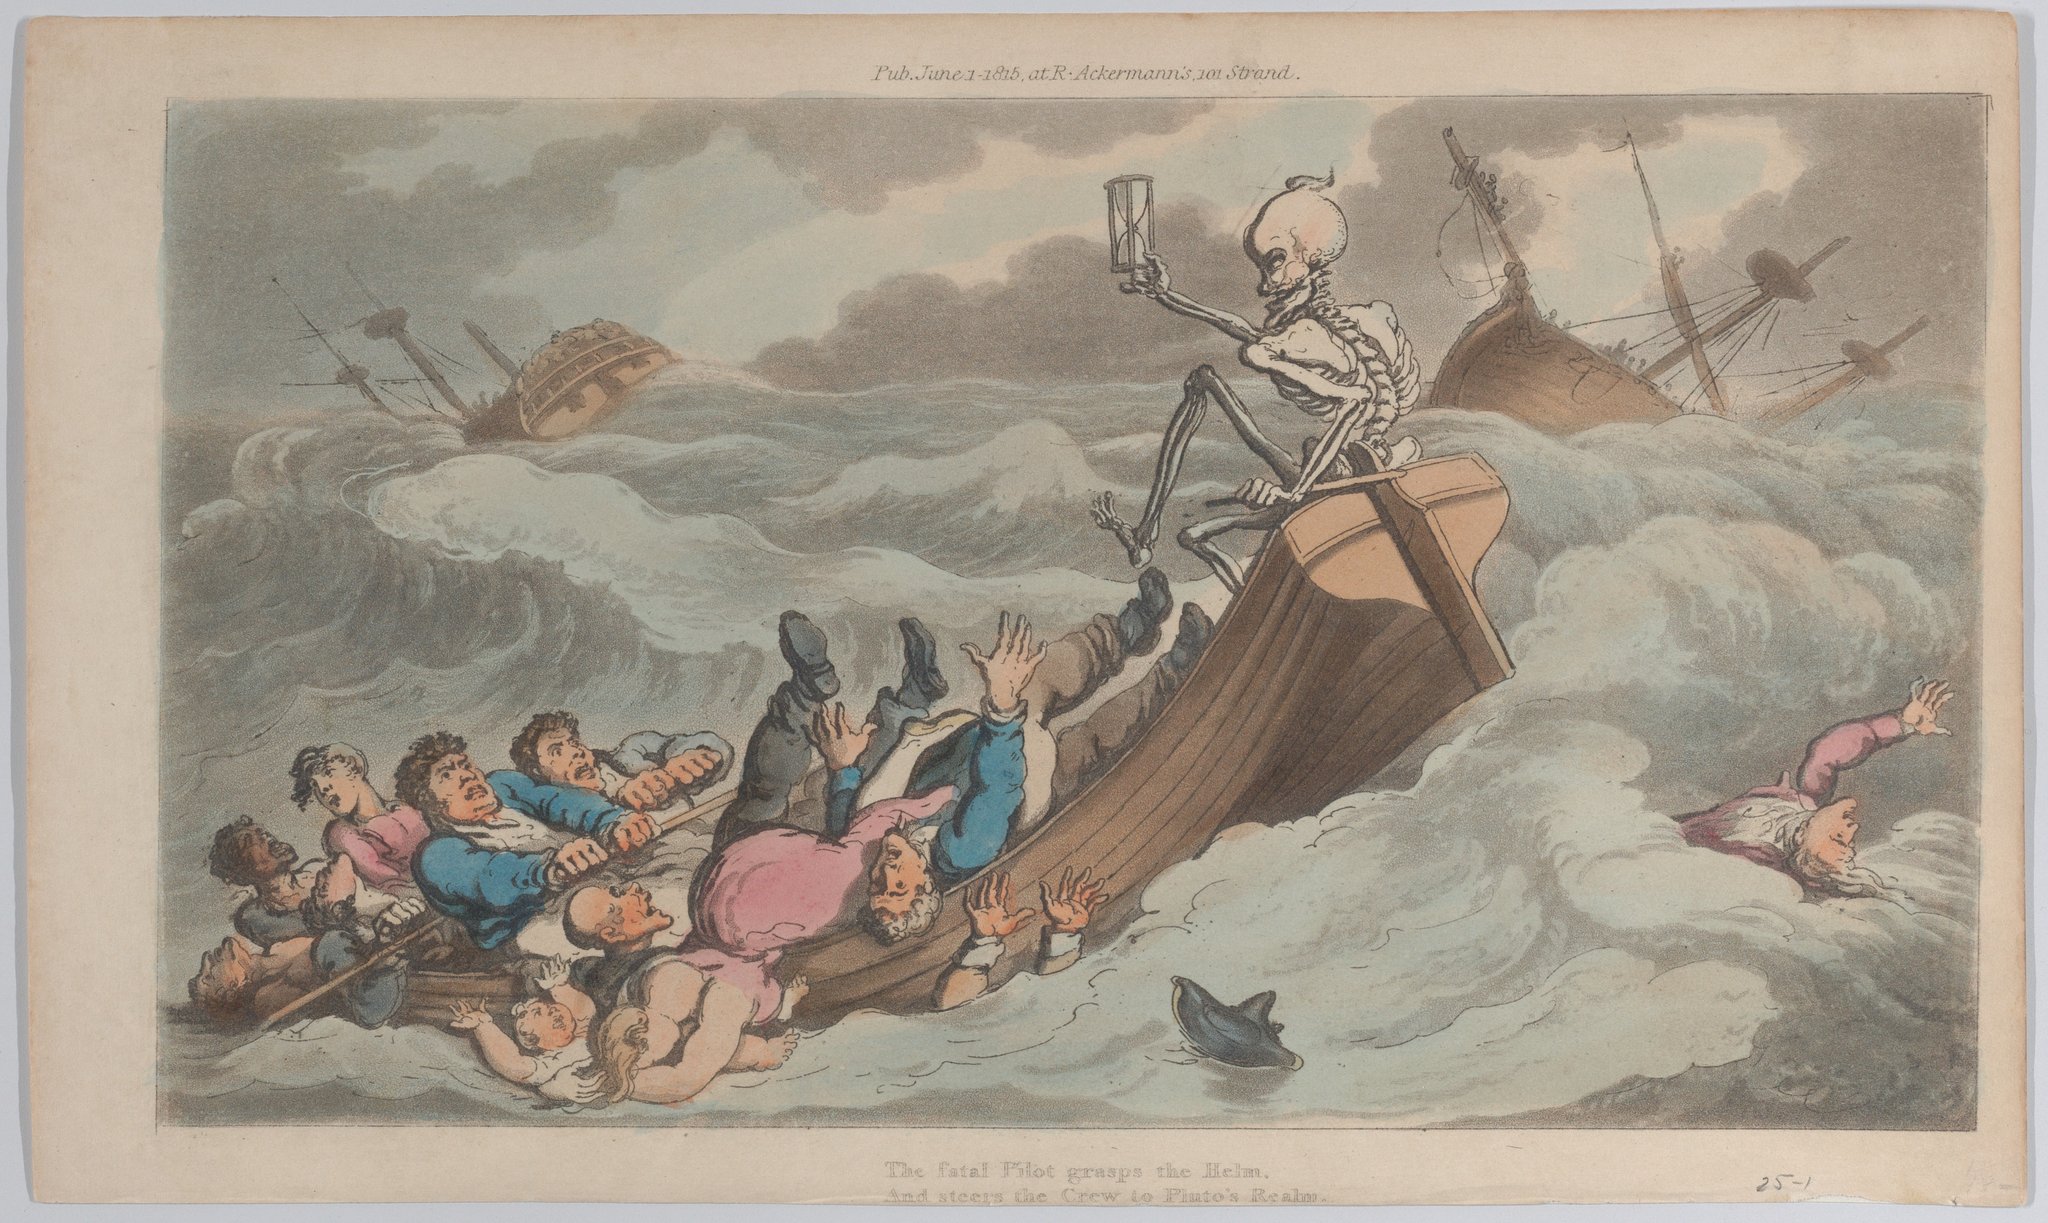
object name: print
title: Death Turned Pilot (from The English Dance of Death, vol. II, pl. 9)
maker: thomas rowlandson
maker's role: artist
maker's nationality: british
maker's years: 1757-1827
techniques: etching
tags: satire,skeletons,men,women,waves,boats